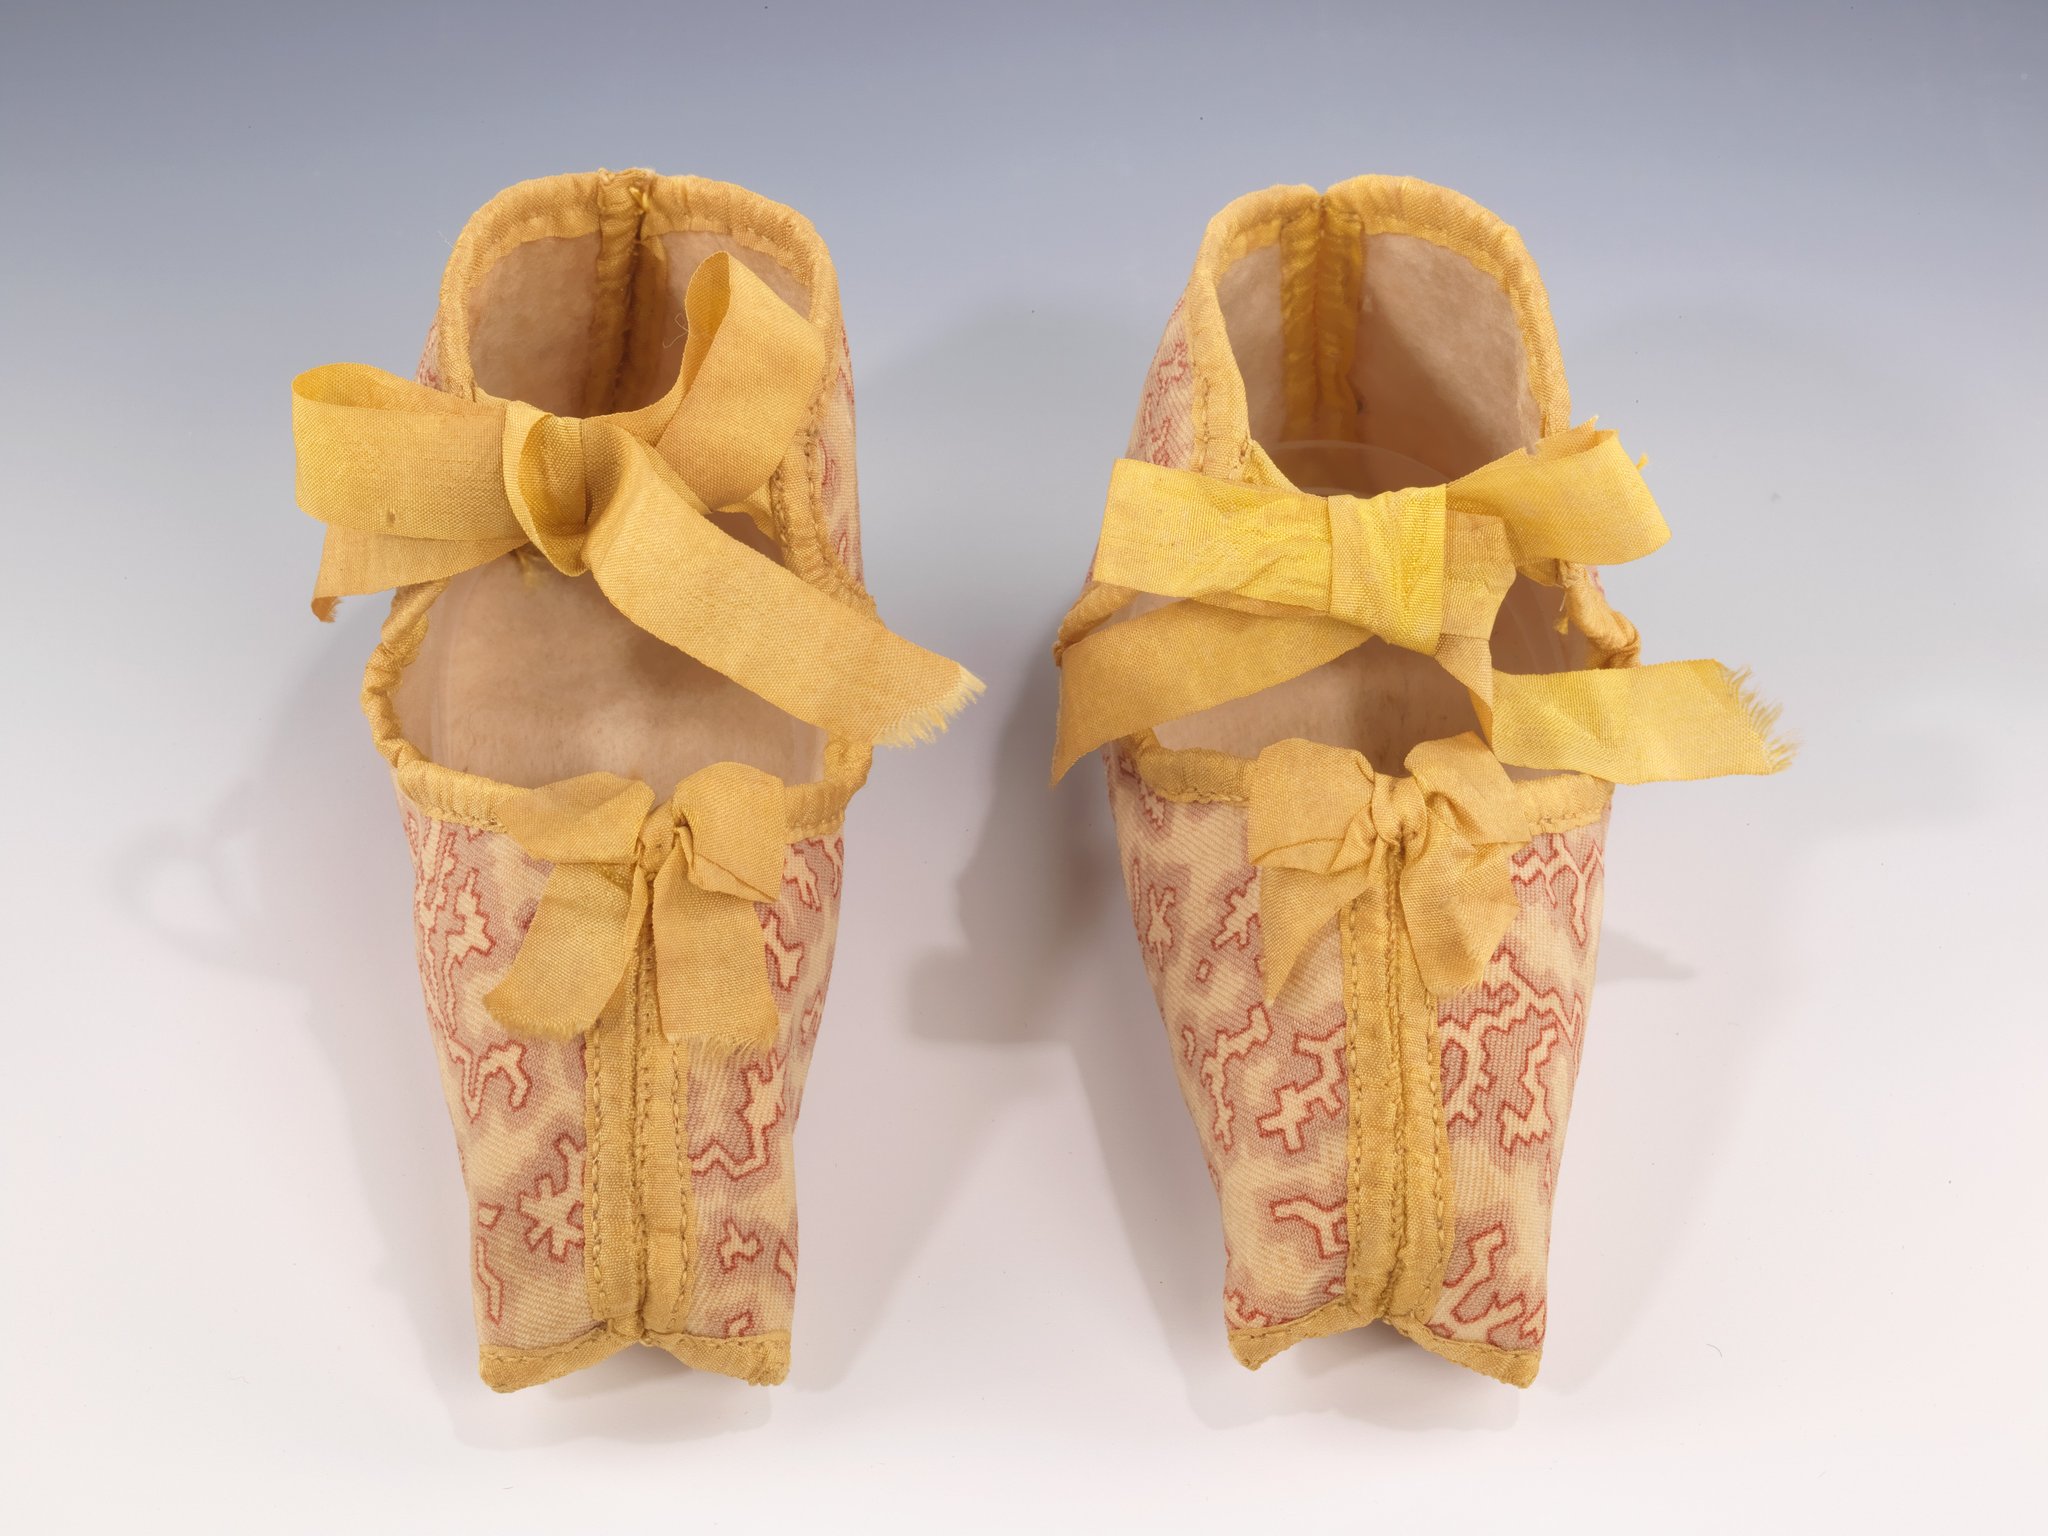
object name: bootee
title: Bootees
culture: american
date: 1840-1850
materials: cotton, silk